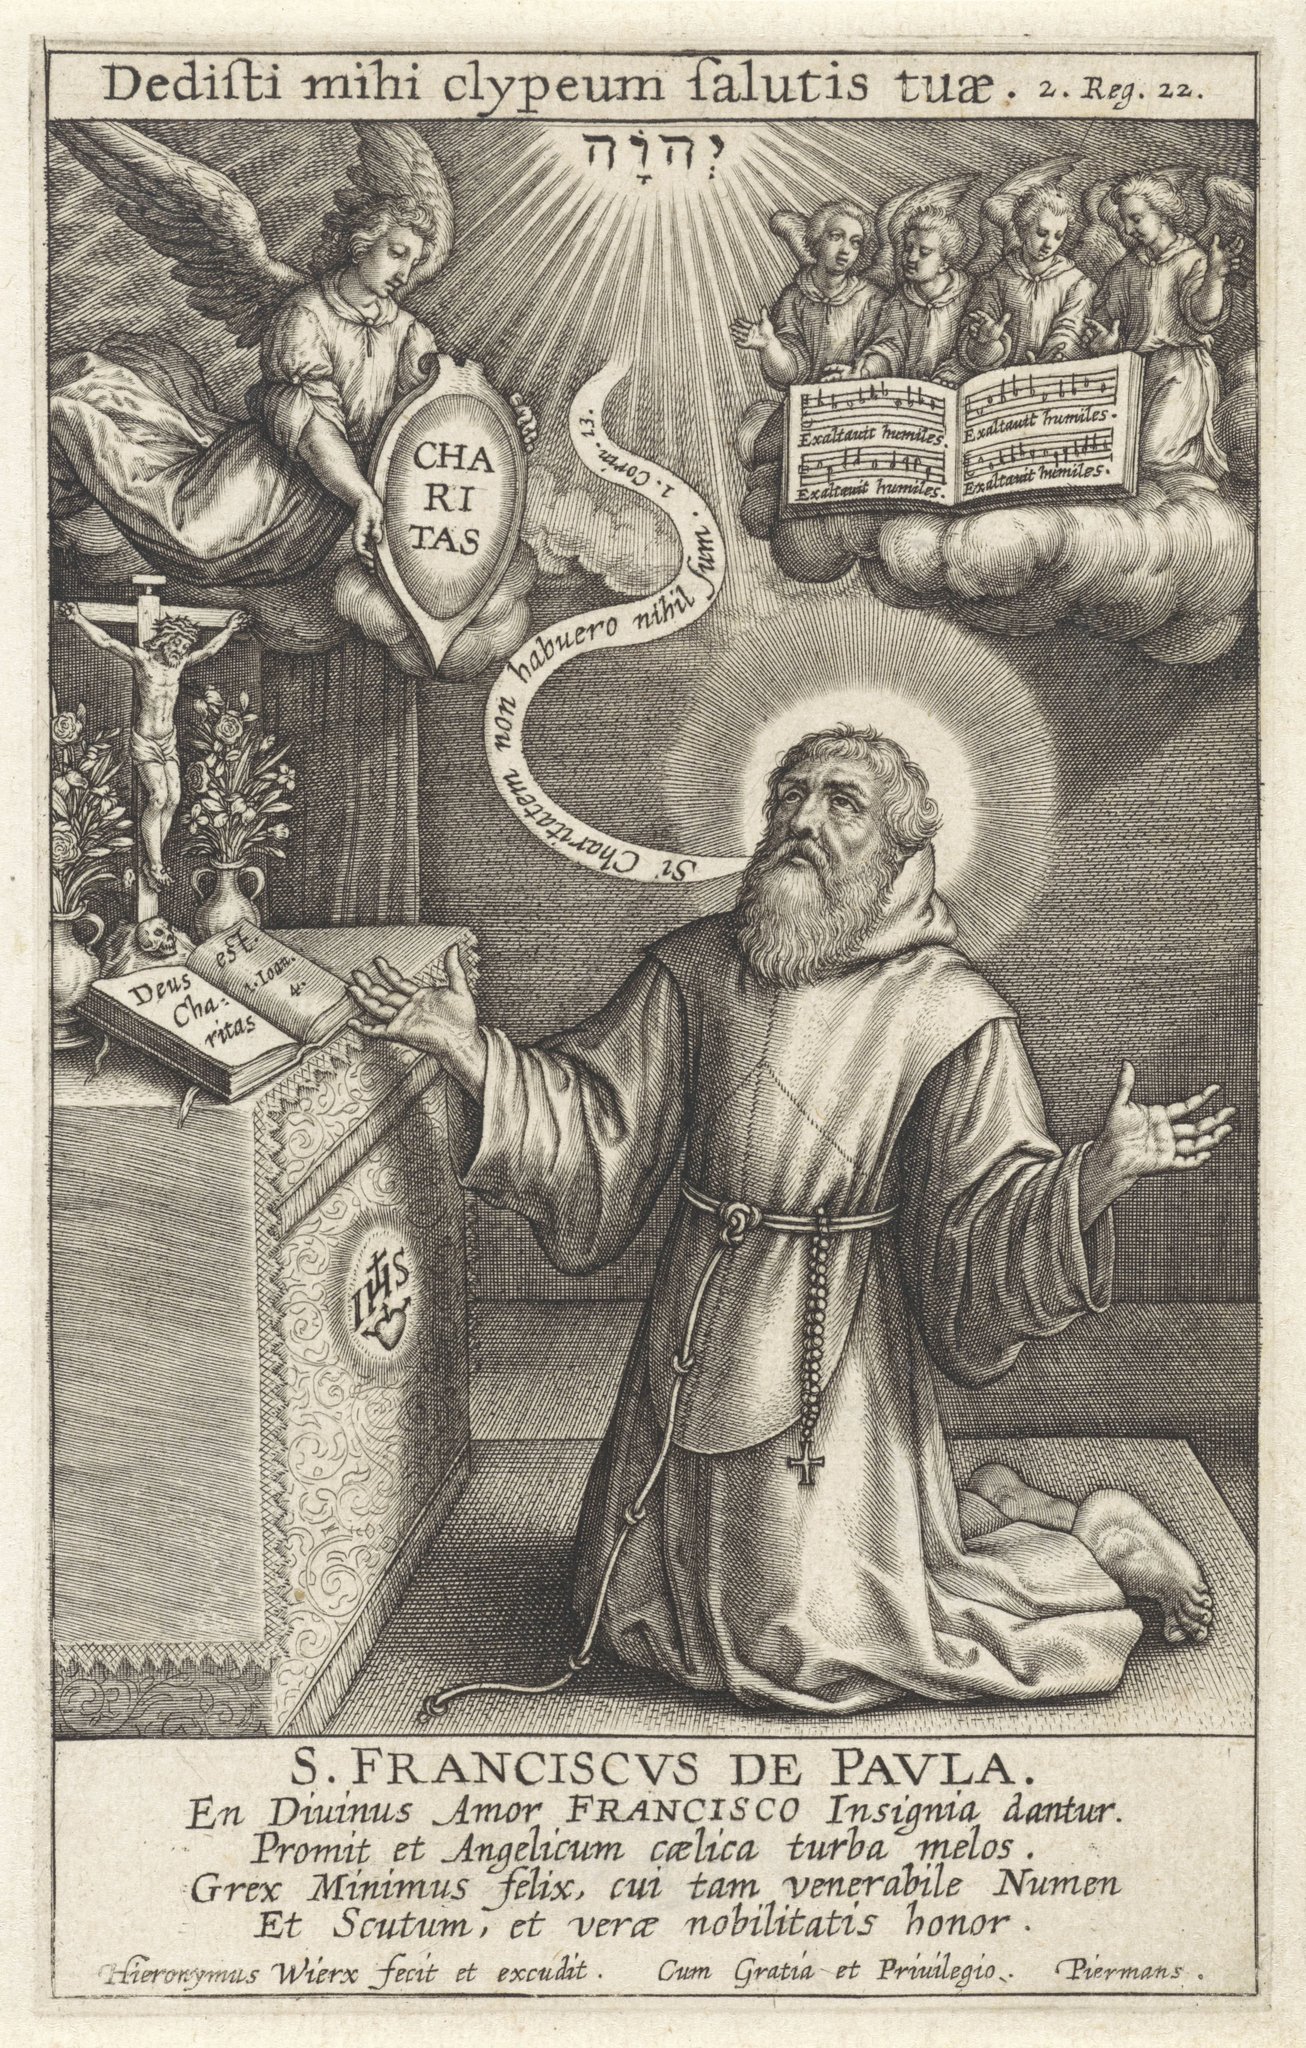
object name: print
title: Engel verschijnt aan H. Franciscus van Paola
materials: paper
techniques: engraving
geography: antwerp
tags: one or more angels appear to st. francis of paola holding a tablet with the inscription 'charitas', tetragram (in roman or hebrew script) ~ symbol of god the father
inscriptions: collector's mark: Lugt 2228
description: De heilige Franciscus van Paola zit geknield voor een altaar, zijn armen gespreid. Hij kijkt op naar een engel die hem een wapenschild toont met de tekst: "Charitas". Boven hem op een wolk zit een engelenkoor met een opengeslagen liedboek. Geheel bovenaan het tetragram, symbool van God de Vader, omgeven door stralen. Het bovenschrift van de prent is een Bijbelcitaat uit 2 Kon. 22 in het Latijn. In de marge een vierregelig onderschrift in het Latijn.